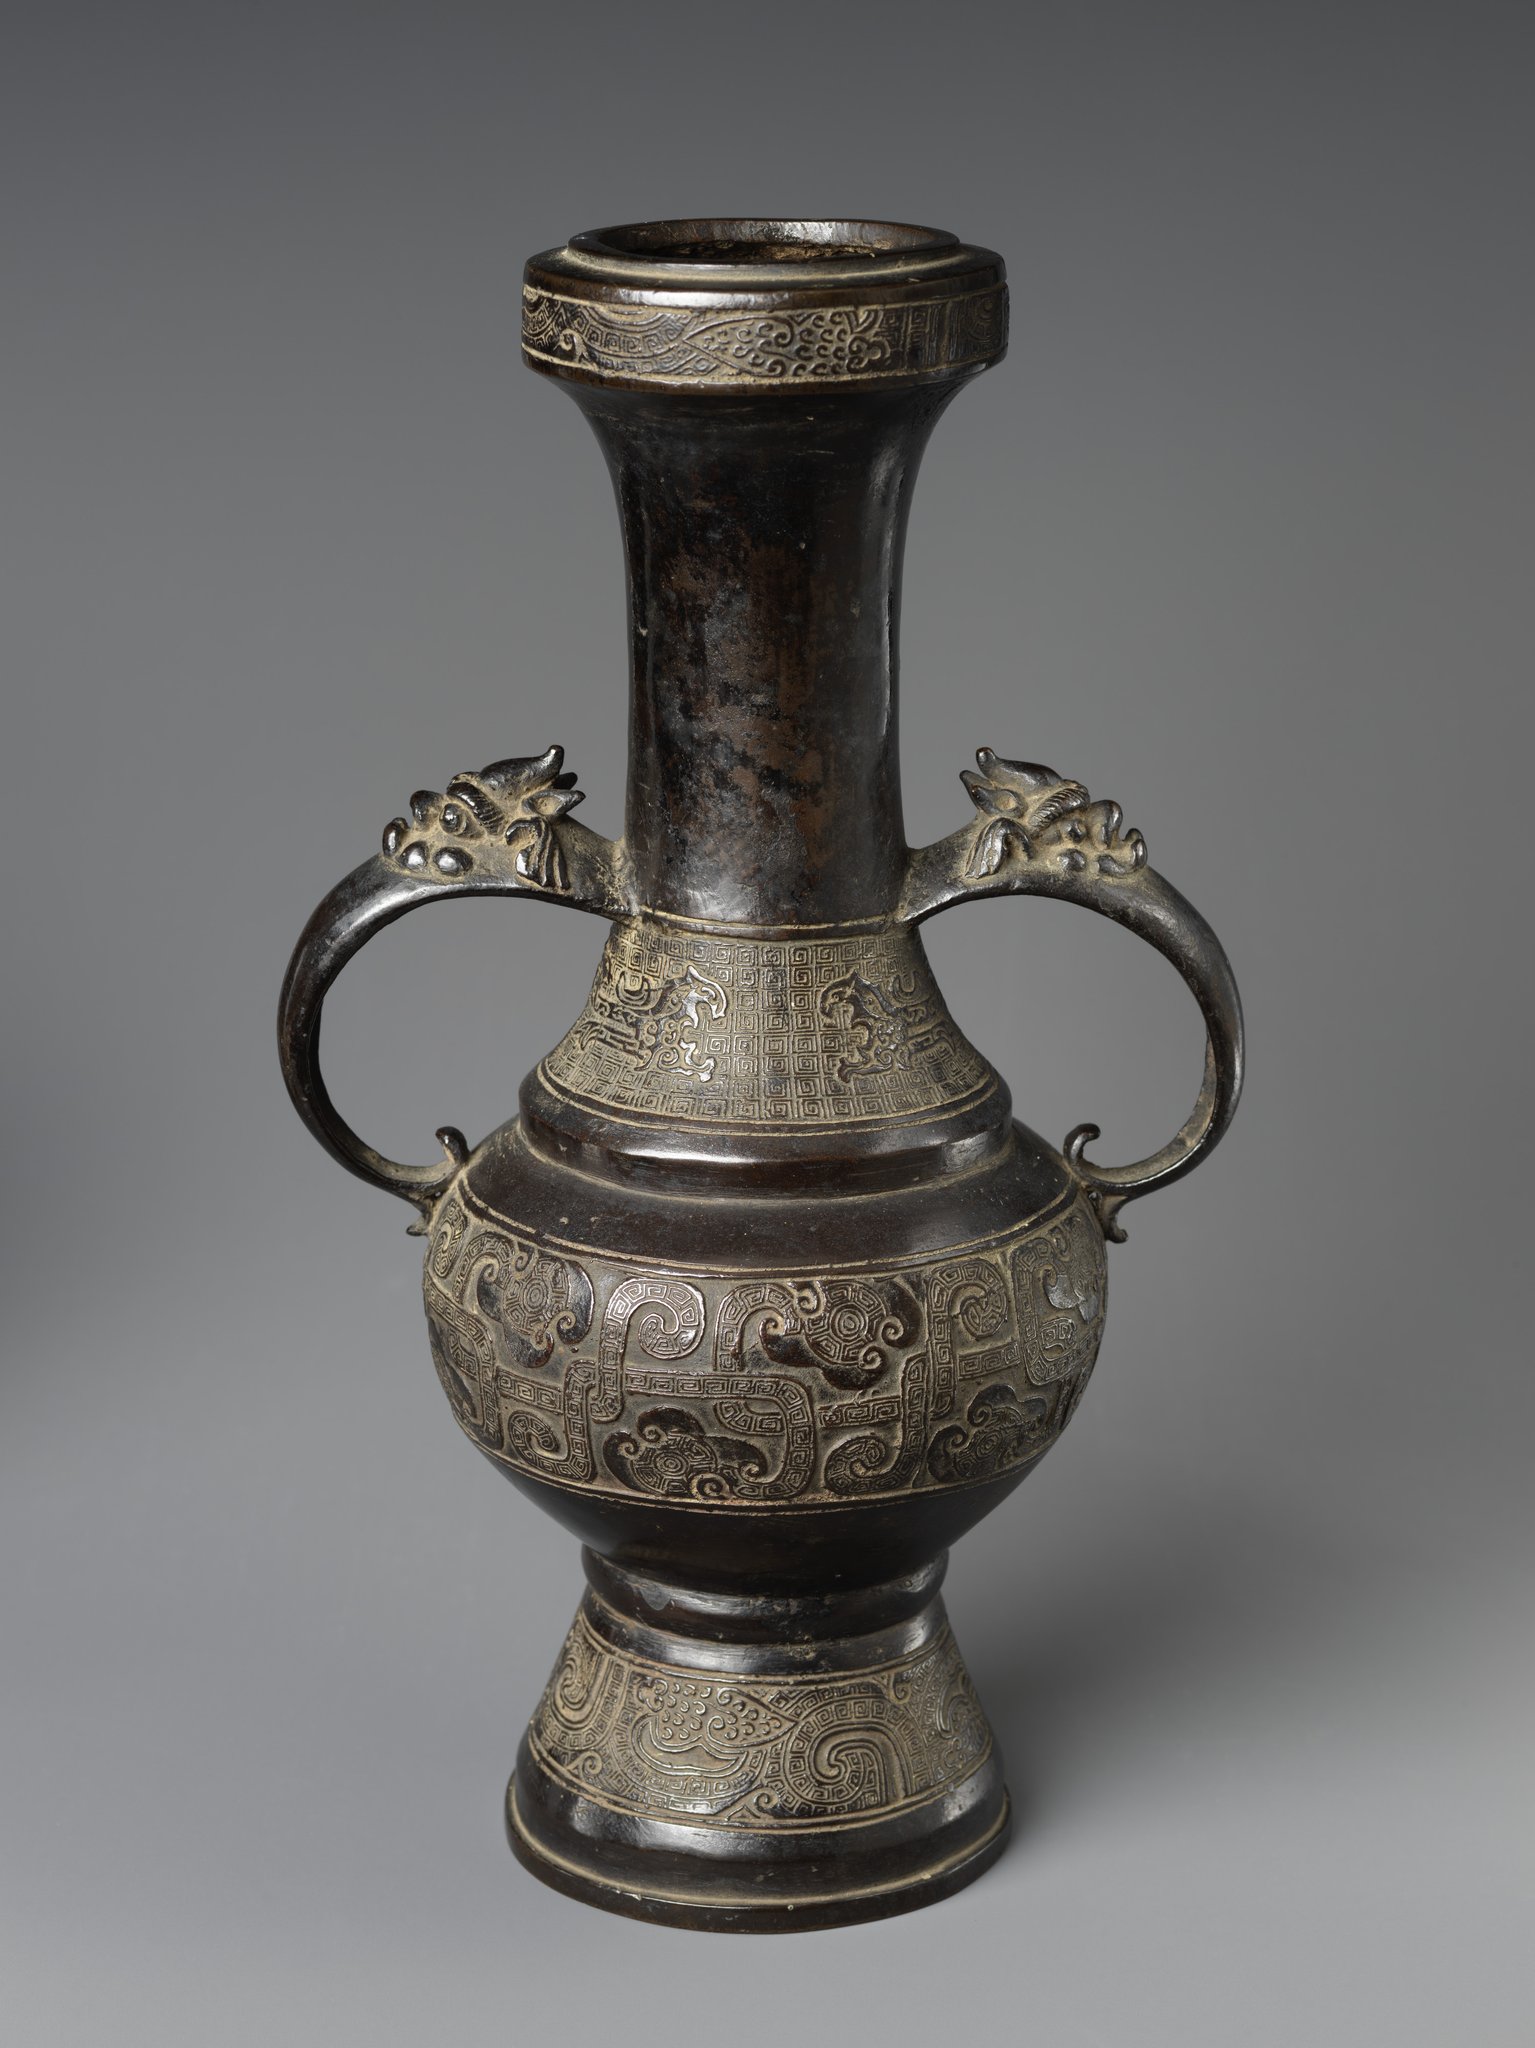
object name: vase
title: Vase with archaic-style motifs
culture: chinese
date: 1301-1400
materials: copper alloy